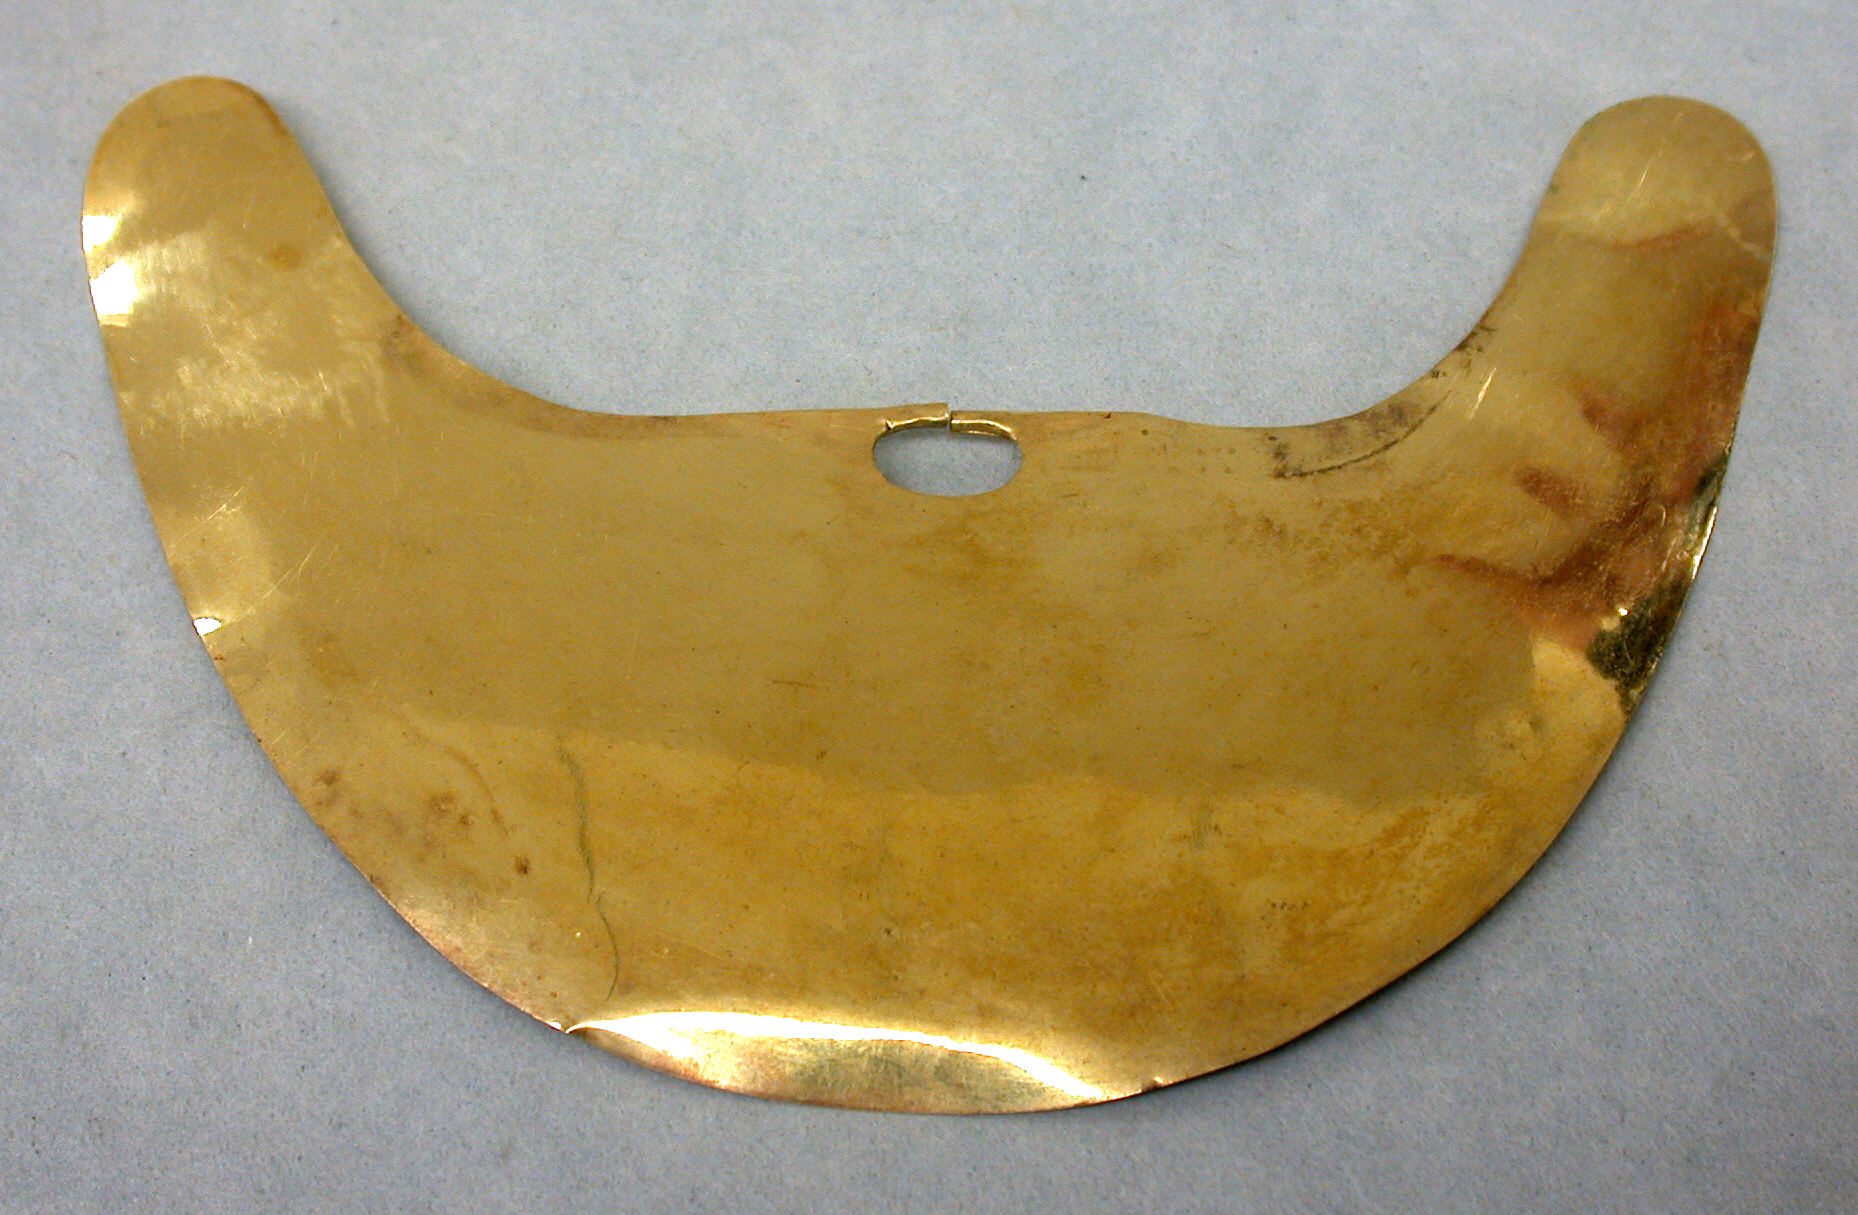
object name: nose ornament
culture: moche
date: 501-700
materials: gold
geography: peru